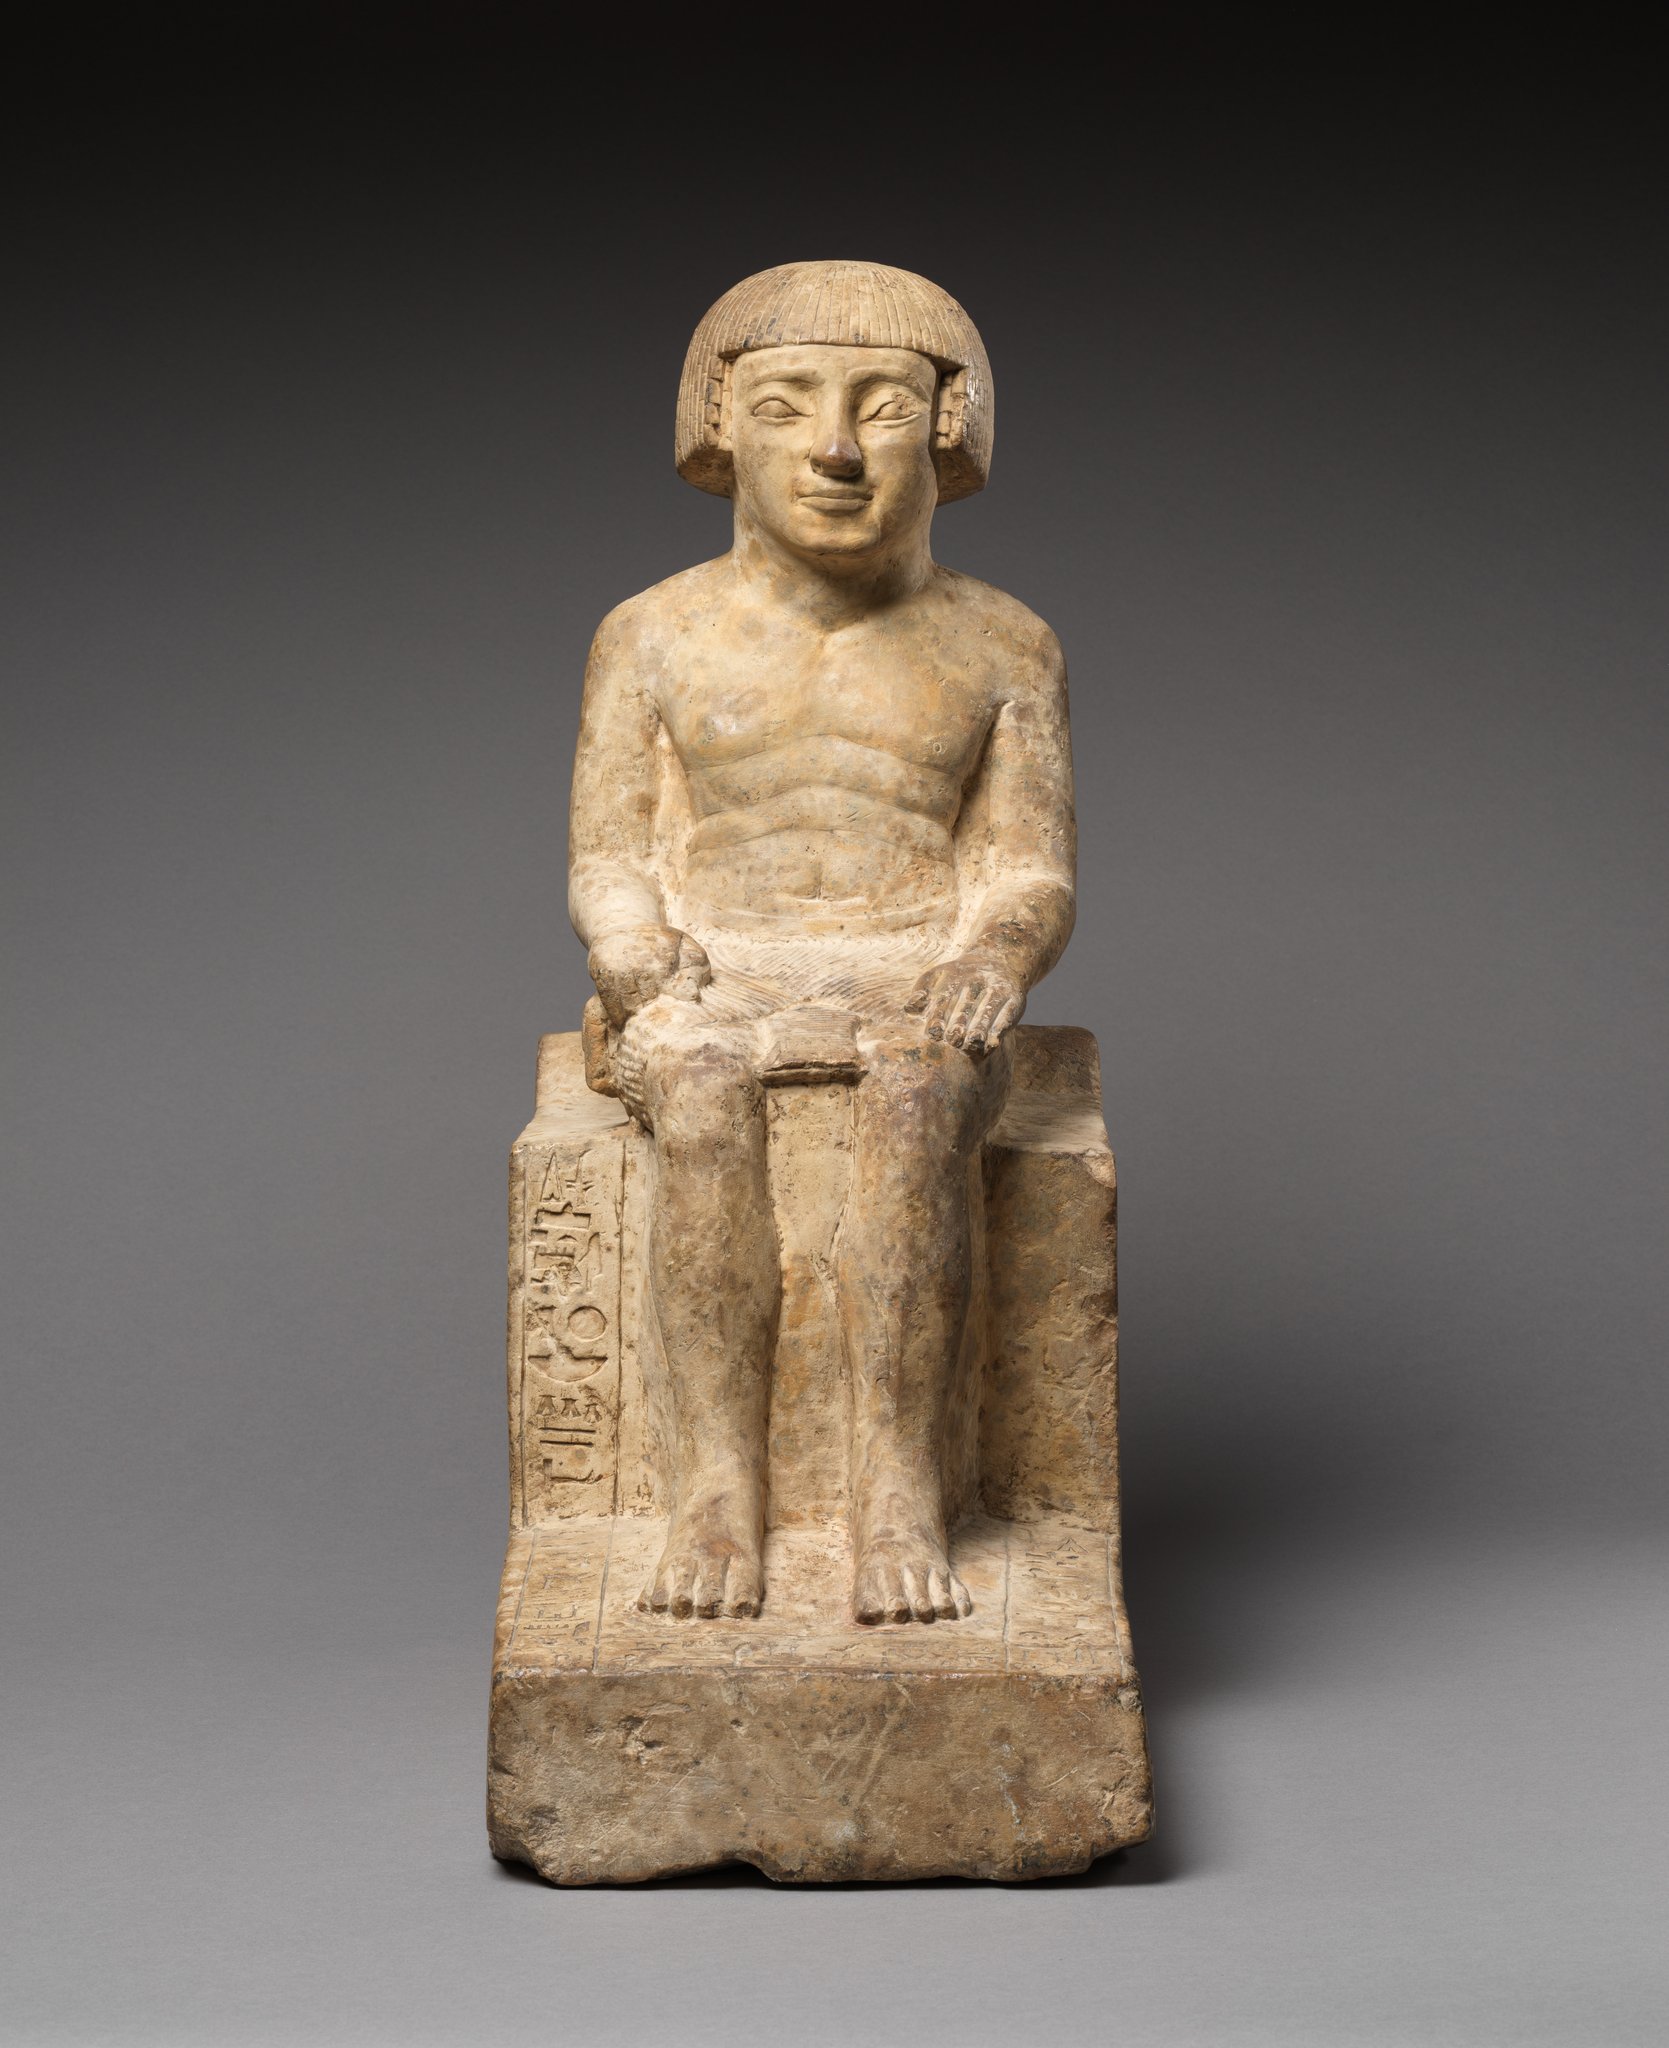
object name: statue, seated man, siamun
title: Statue of Siamun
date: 1580-1550 BCE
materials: limestone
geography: egypt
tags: kings